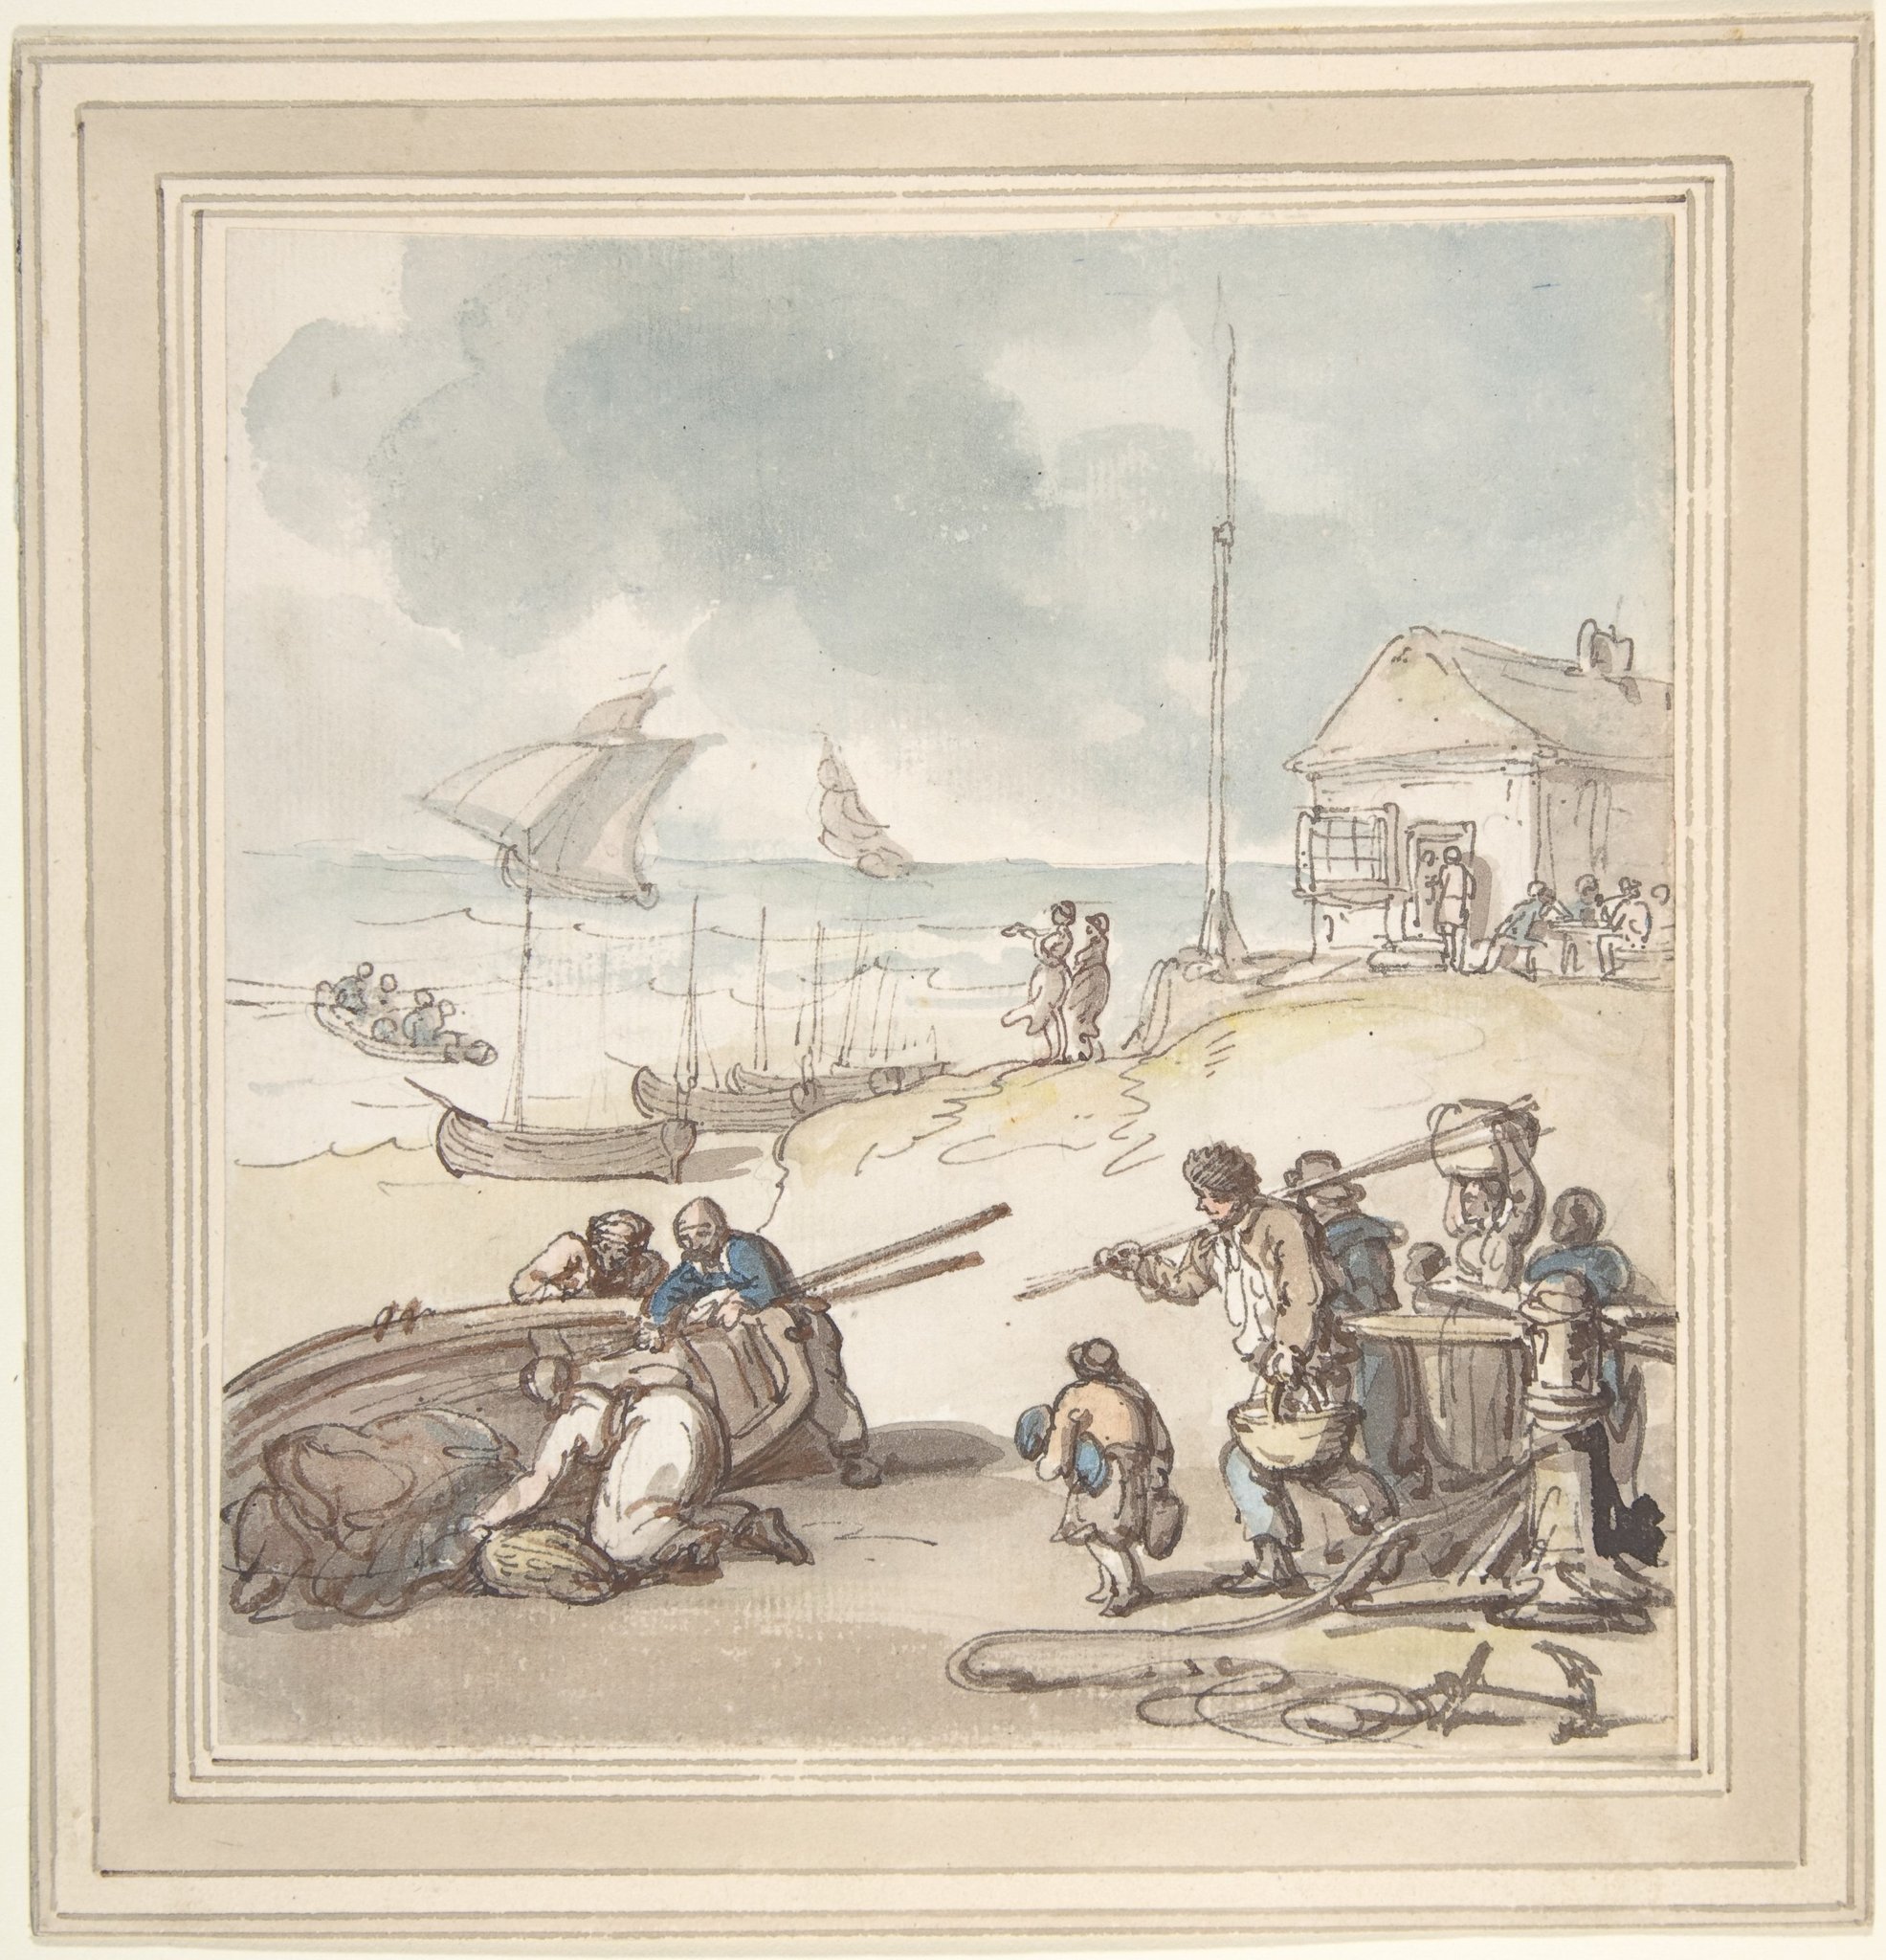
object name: drawing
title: Figures by the Seashore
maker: thomas rowlandson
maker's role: artist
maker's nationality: british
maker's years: 1757-1827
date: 1767-1833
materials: ink, watercolor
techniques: pen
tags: men,women,boats